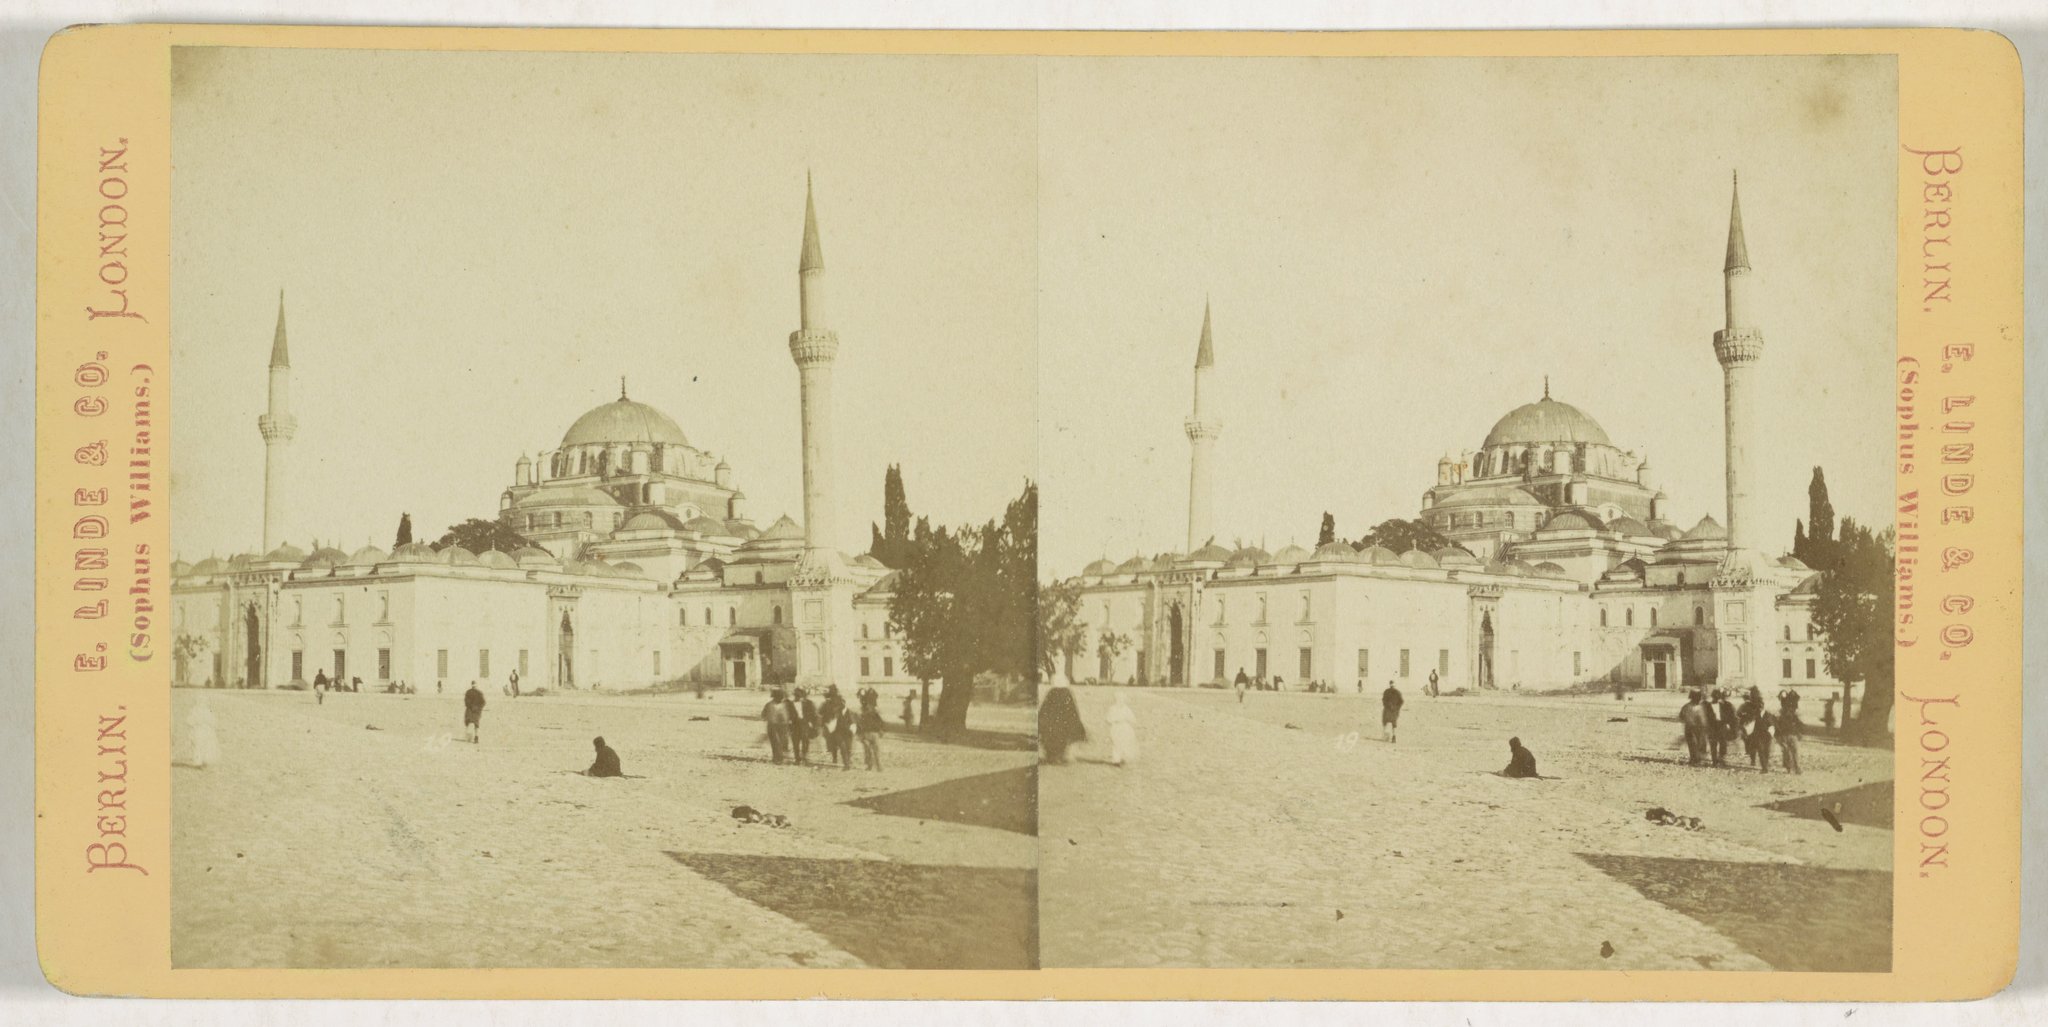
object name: stereograph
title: Bayezid II moskee in Istanboel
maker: Anonymous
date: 1873-1890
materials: cardboard, paper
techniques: albumen print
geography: bayezid ii moskee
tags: temple, shrine ~ islam, mohammedanism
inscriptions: number: ‘19’